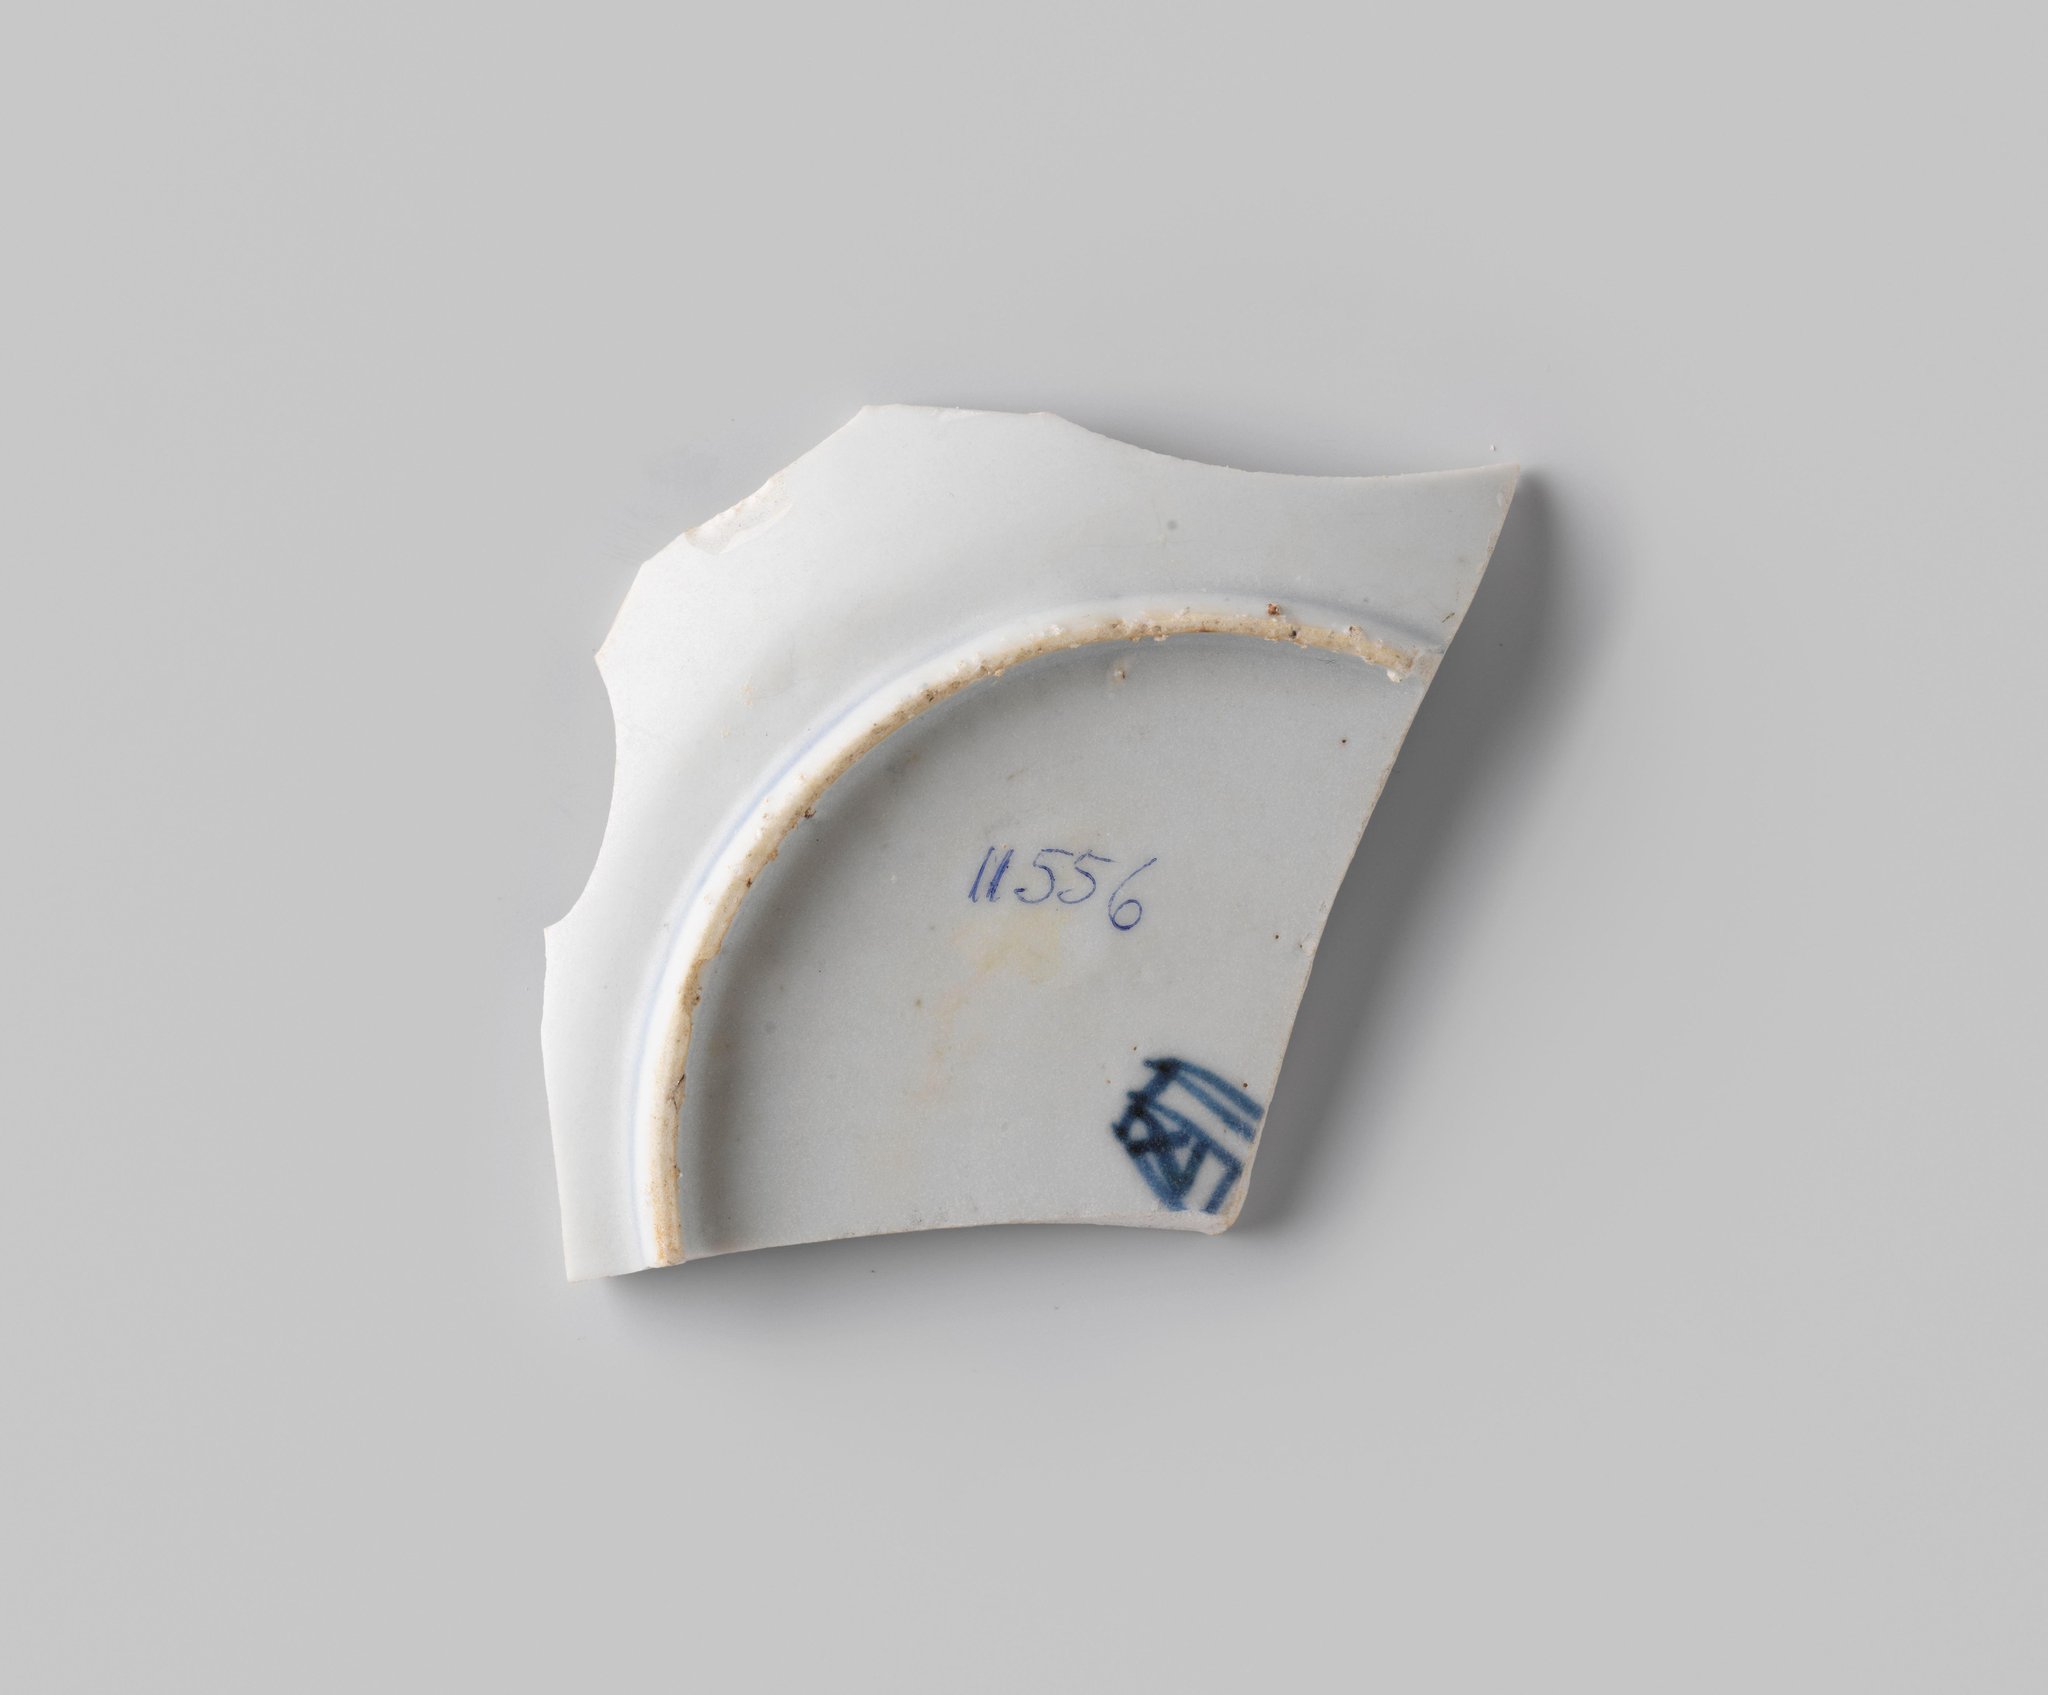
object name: sherd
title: Fragment bord uit V.O.C.-schip de 'Witte Leeuw'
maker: Anonymous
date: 1613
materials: porcelain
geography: jingdezhen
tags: verenigde oostindische compagnie, sint-helena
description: A base sherd. In the centre part of a shrimp (?) is visible. On the base part of a 4-character mark: fu kuei...